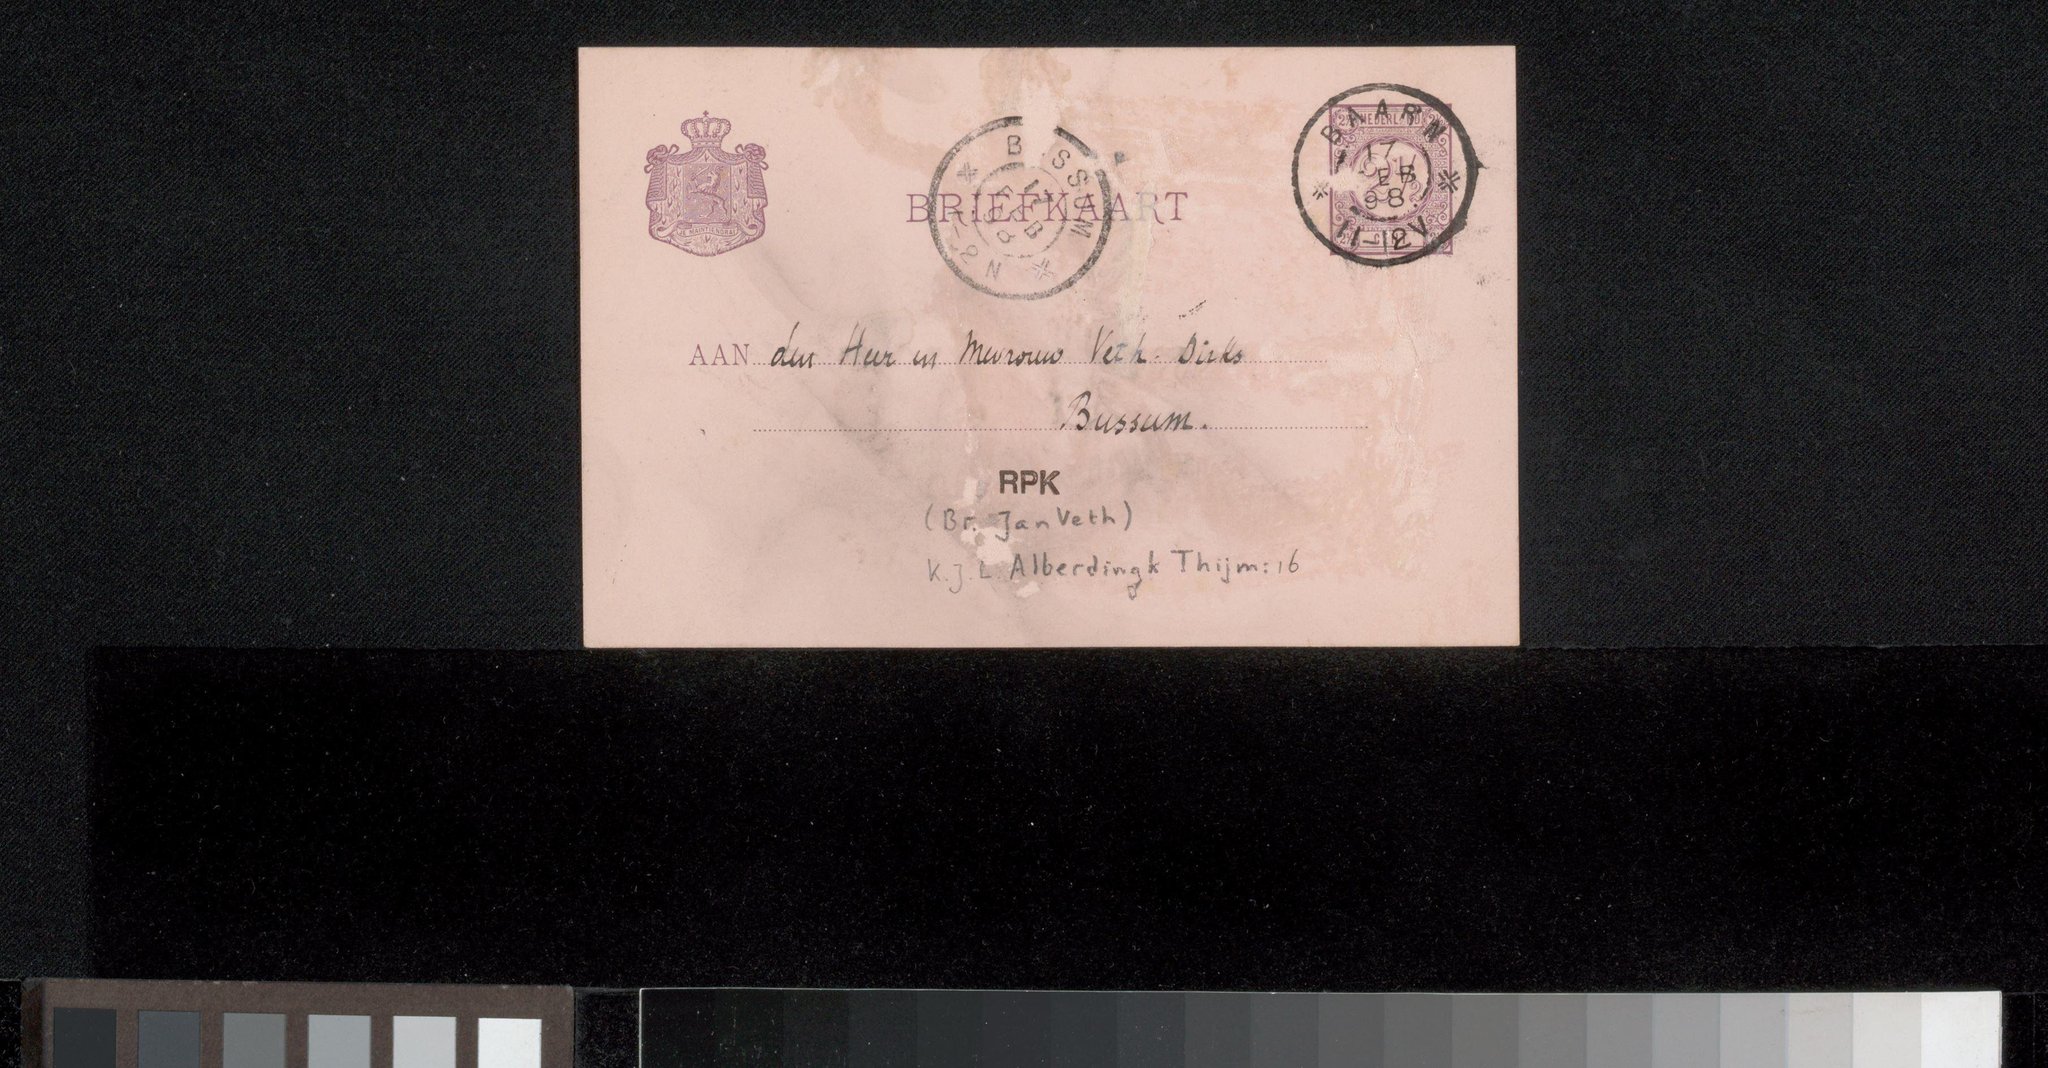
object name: postcard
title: Briefkaart aan Jan Veth en Anna Dorothea Dirks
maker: karel johan lodewijk alberdingk thijm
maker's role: criticus, prozaschrijver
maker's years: 1864-1952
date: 1898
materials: cardboard, ink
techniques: pen, writing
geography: baarn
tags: dordrecht, amsterdam, painter, draughtsman, designer, jan veth, artist, anna dorothea dirks, family life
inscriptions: collector's mark: ‘RPK’